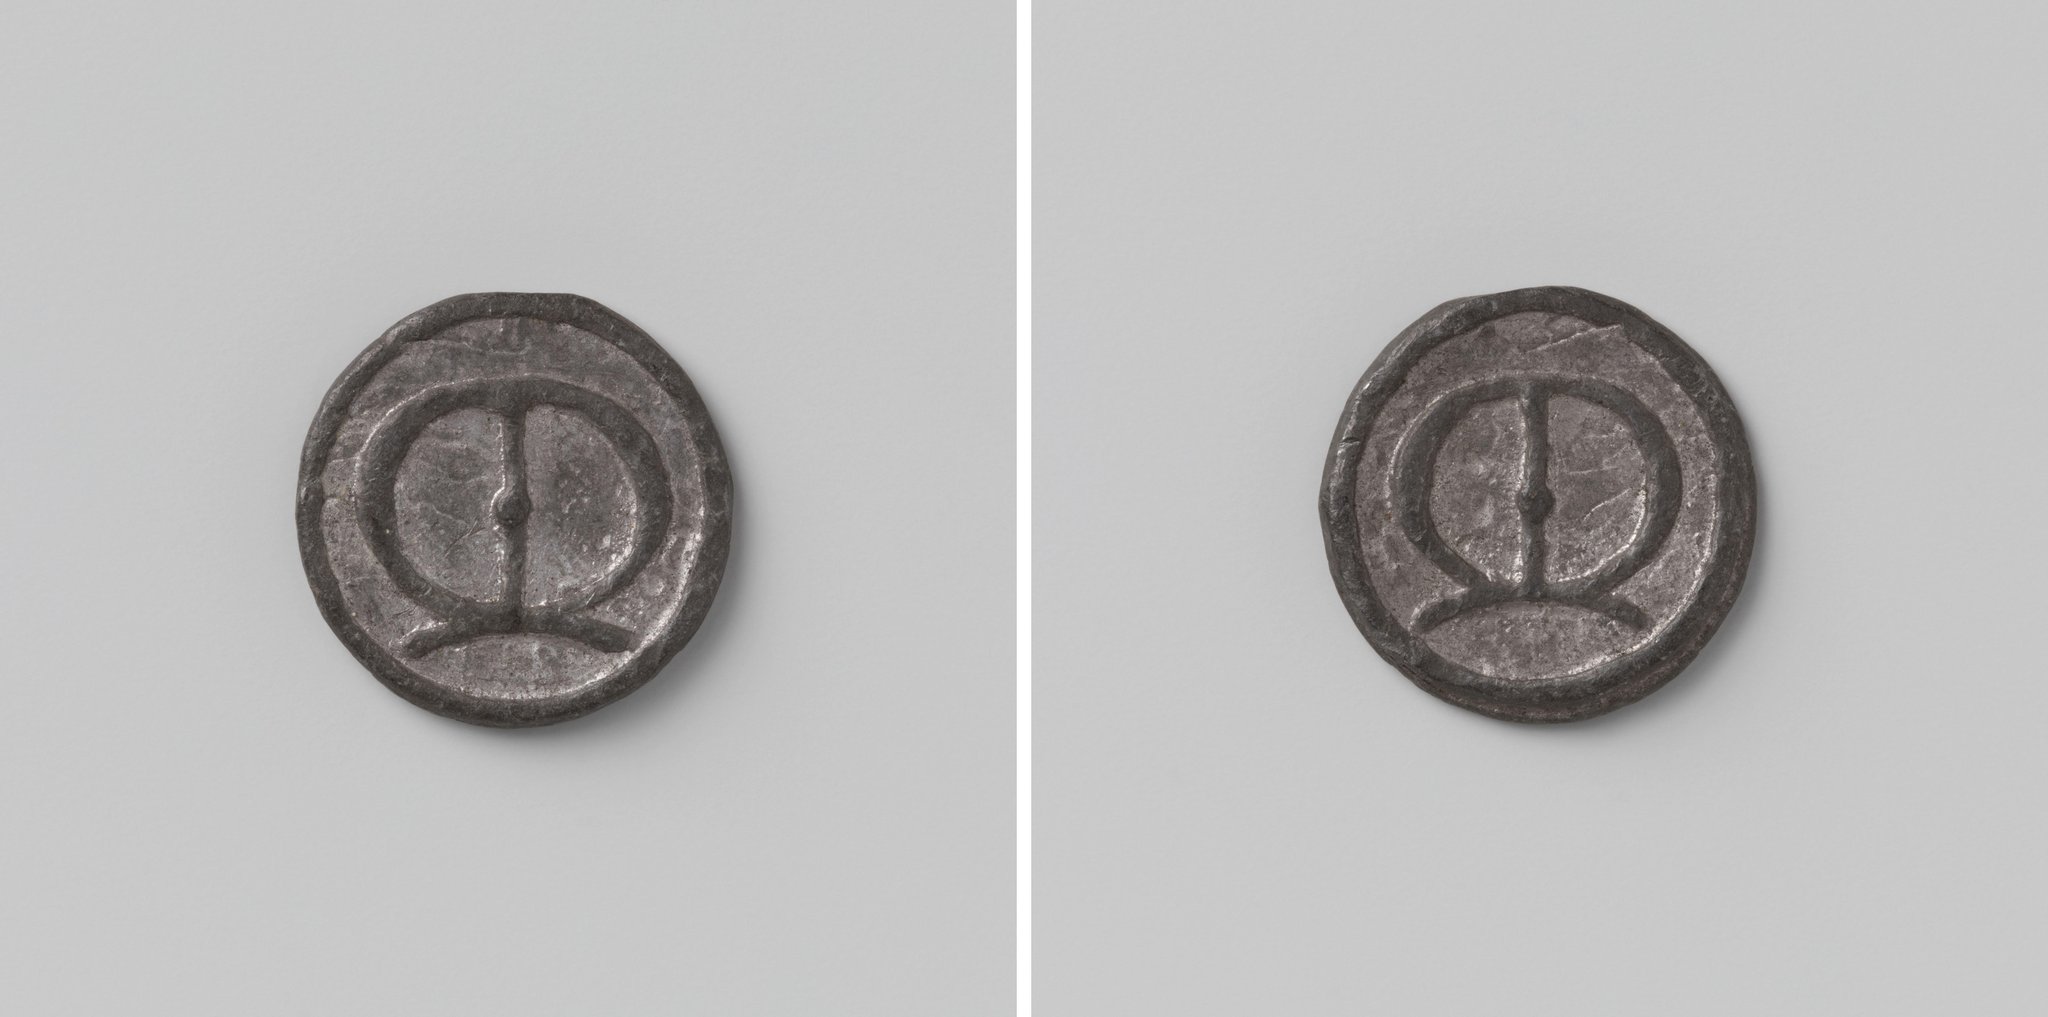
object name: oord, oortje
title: Parochie Oudenaarde, presentiepenning ter waarde van een Brabantse oord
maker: Anonymous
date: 1795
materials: lead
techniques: striking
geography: oudenaarde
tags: oudenaarde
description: Loden penning. Voorzijde: letter A in Gothisch schrift. Keerzijde: letter A in Gothisch schrift.